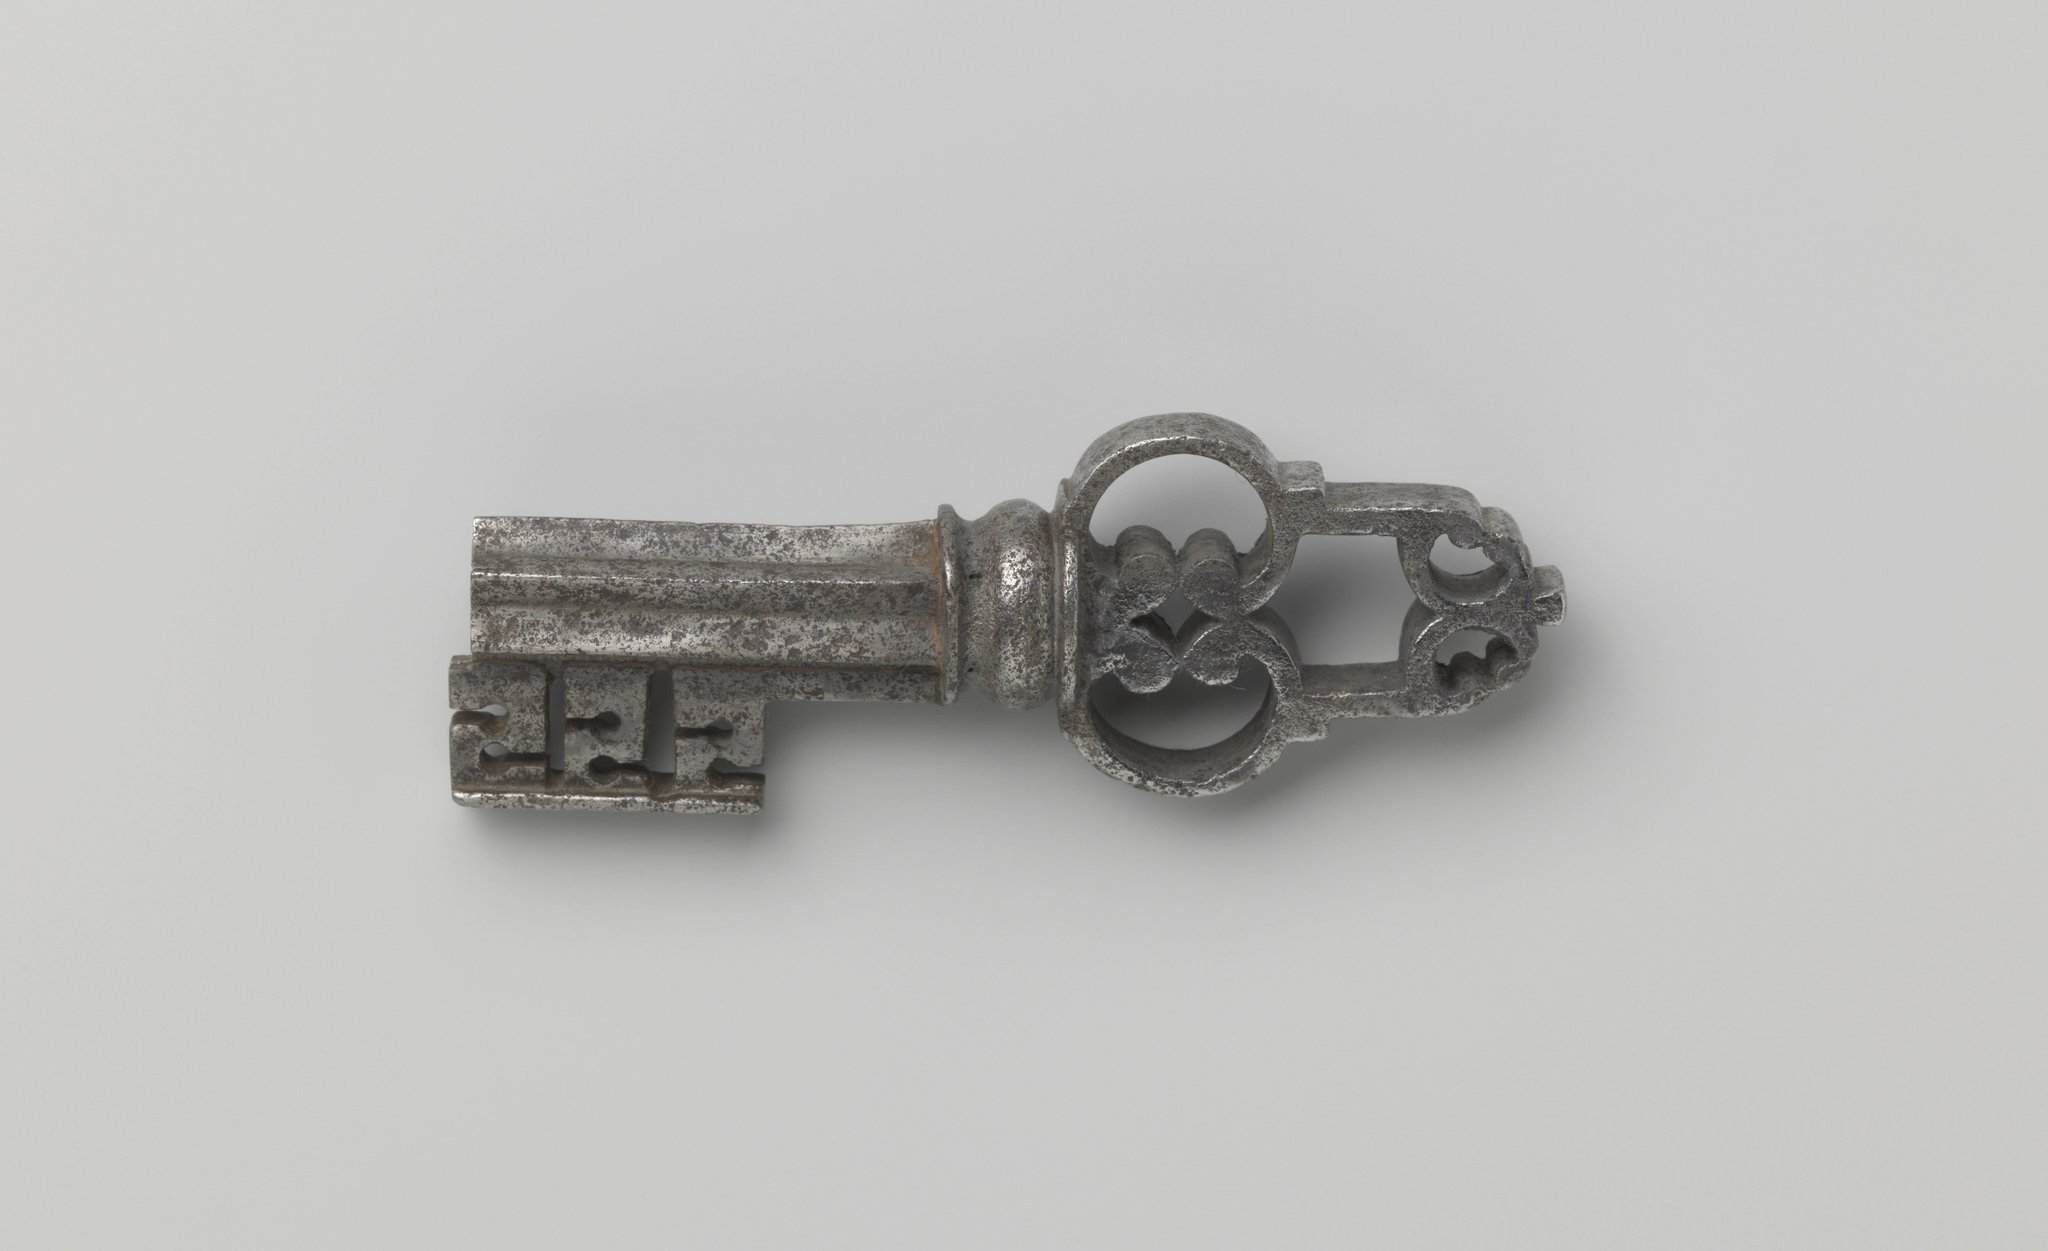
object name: key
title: Sleutel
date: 1400-1950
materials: iron